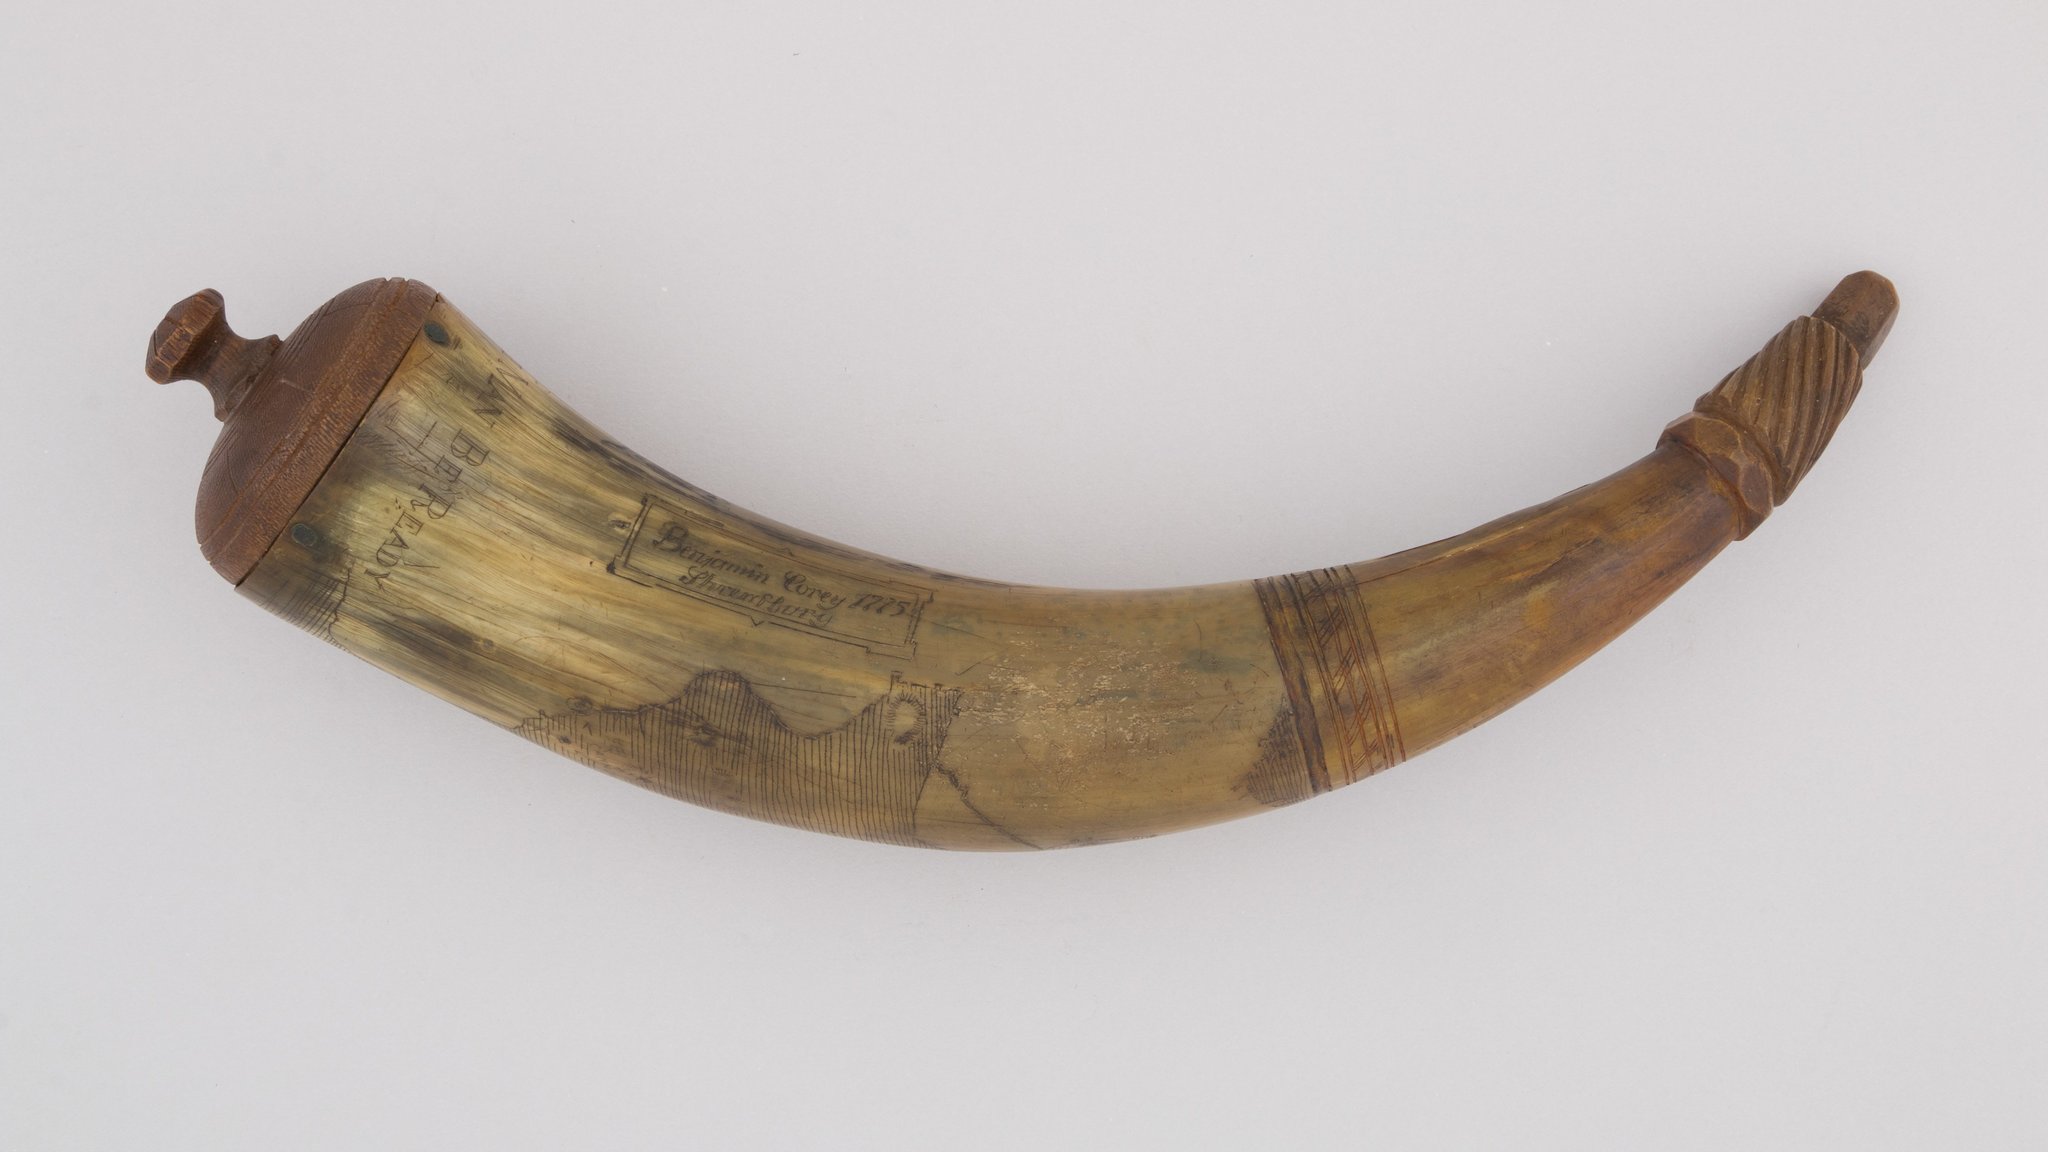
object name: powder horn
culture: colonial american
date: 1775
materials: horn, wood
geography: united states